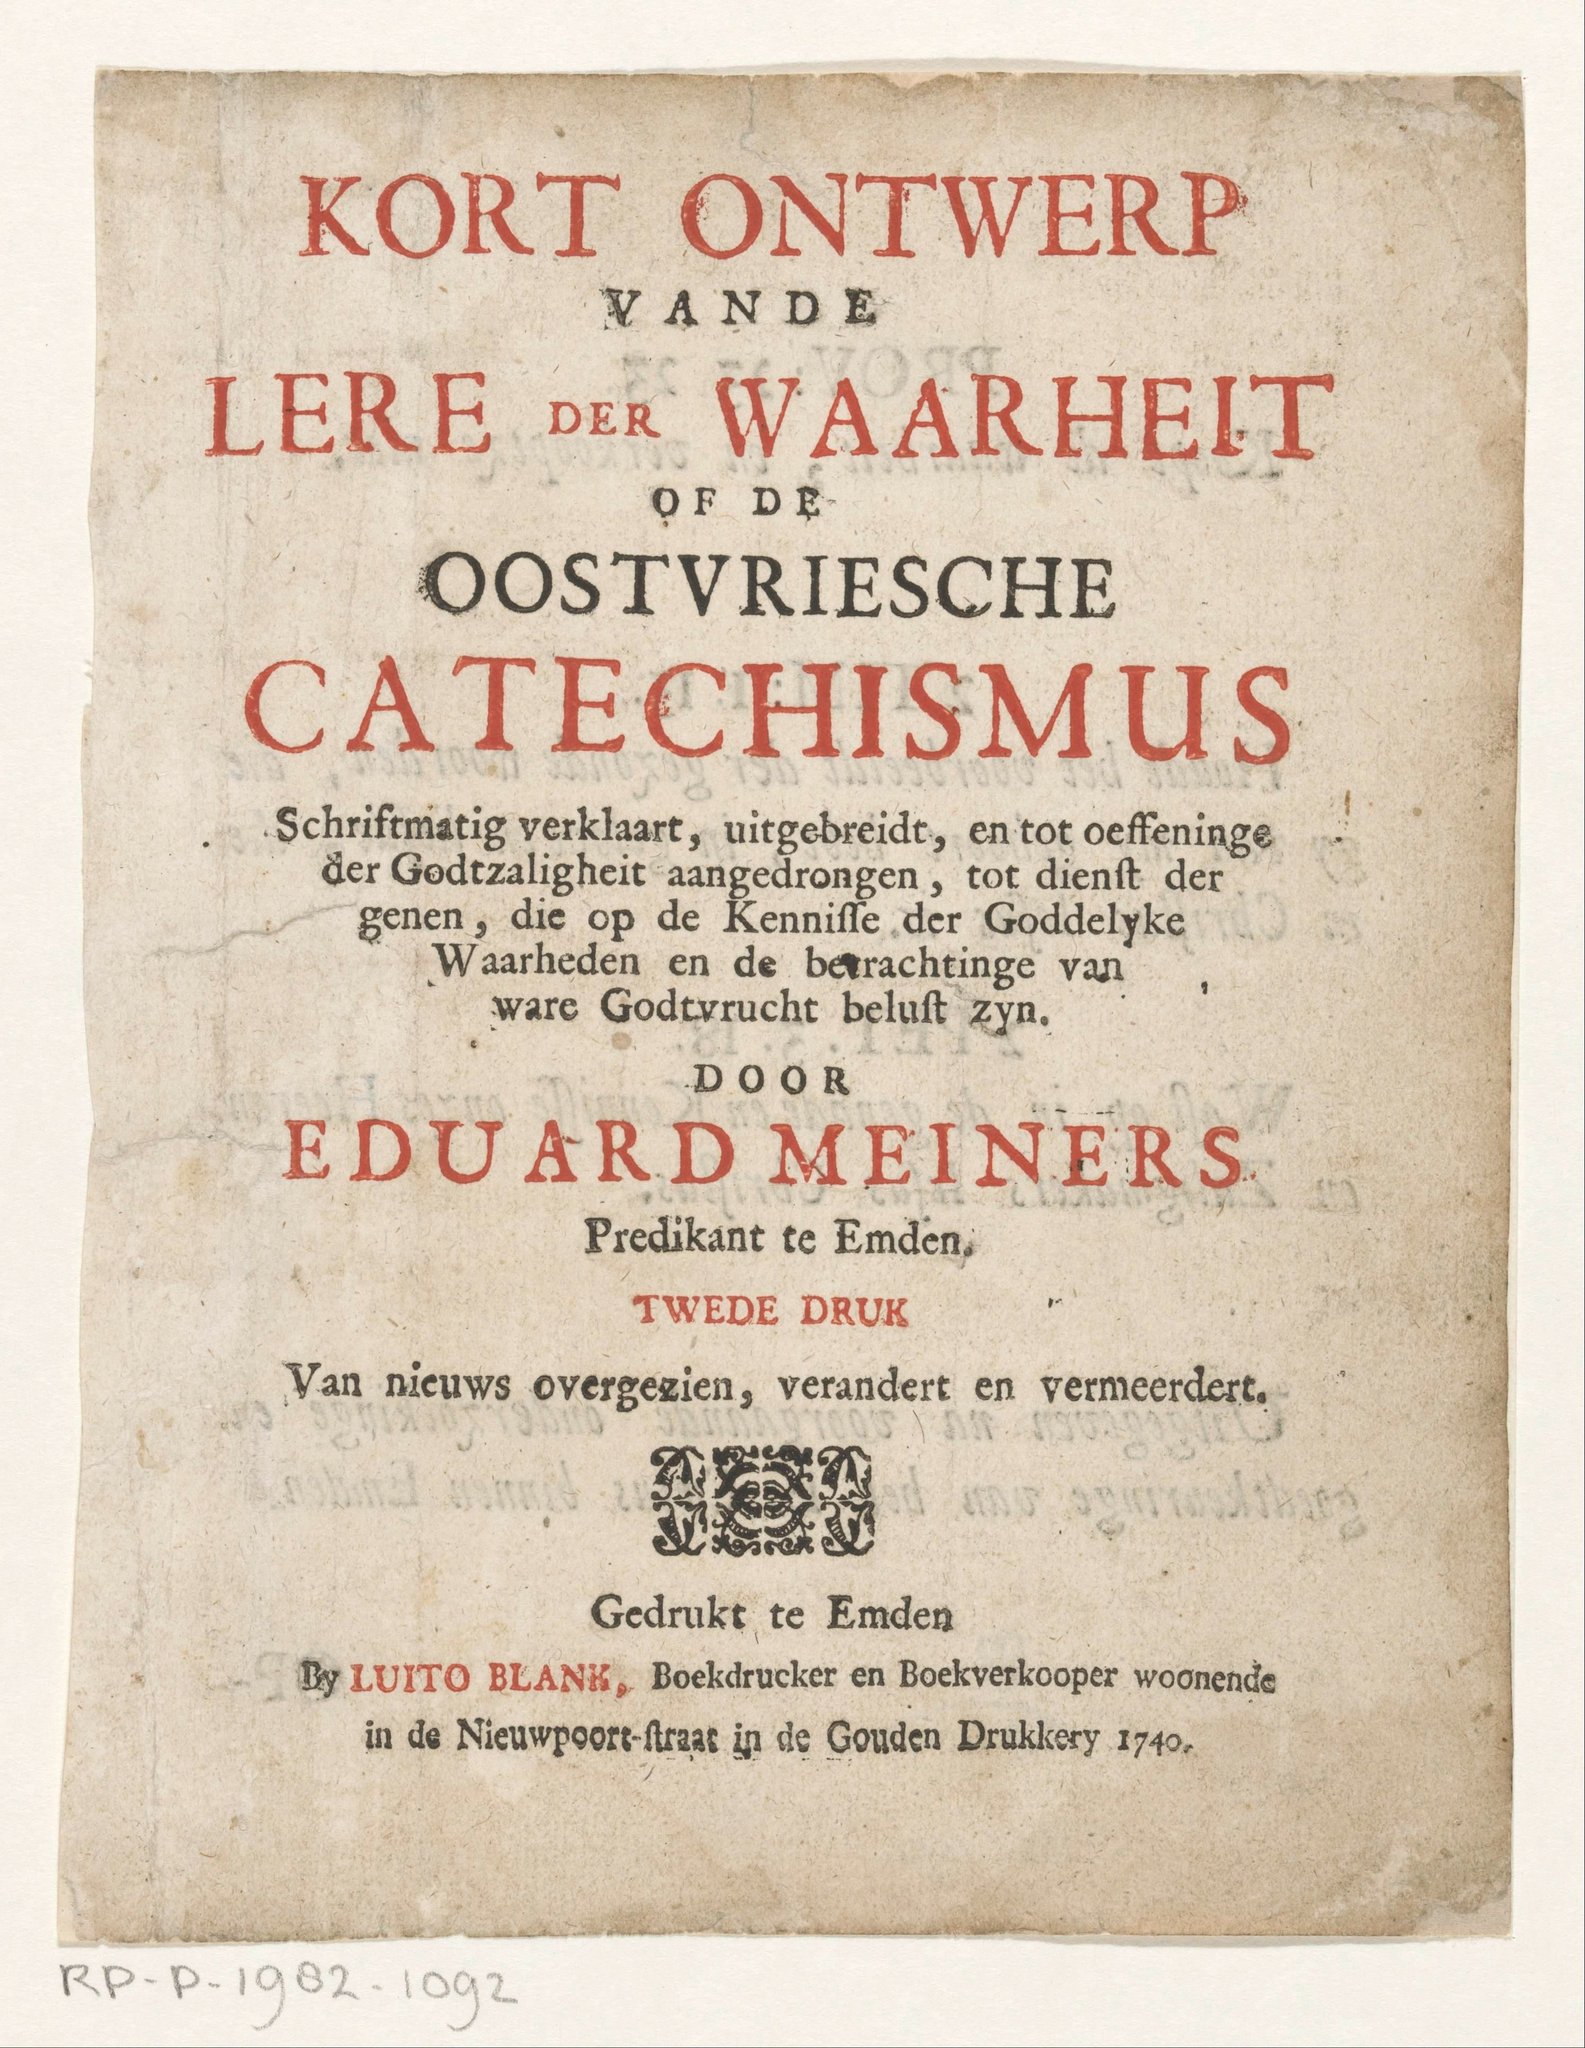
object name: print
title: Titelpagina voor: Eduard Meiners, Kort ontwerp van de lere der waarheit of de Oostvriesche catechismus, 1740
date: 1740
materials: paper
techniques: letterpress printing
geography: emden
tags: title-page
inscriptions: collector's mark: Lugt 2228, collector's mark: Lugt 2760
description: Titelpagina voor: Meiners, Eduard. Kort ontwerp van de lere der waarheit of de Oostvriesche catechismus. Emden: Blanck, Luito, 1740.